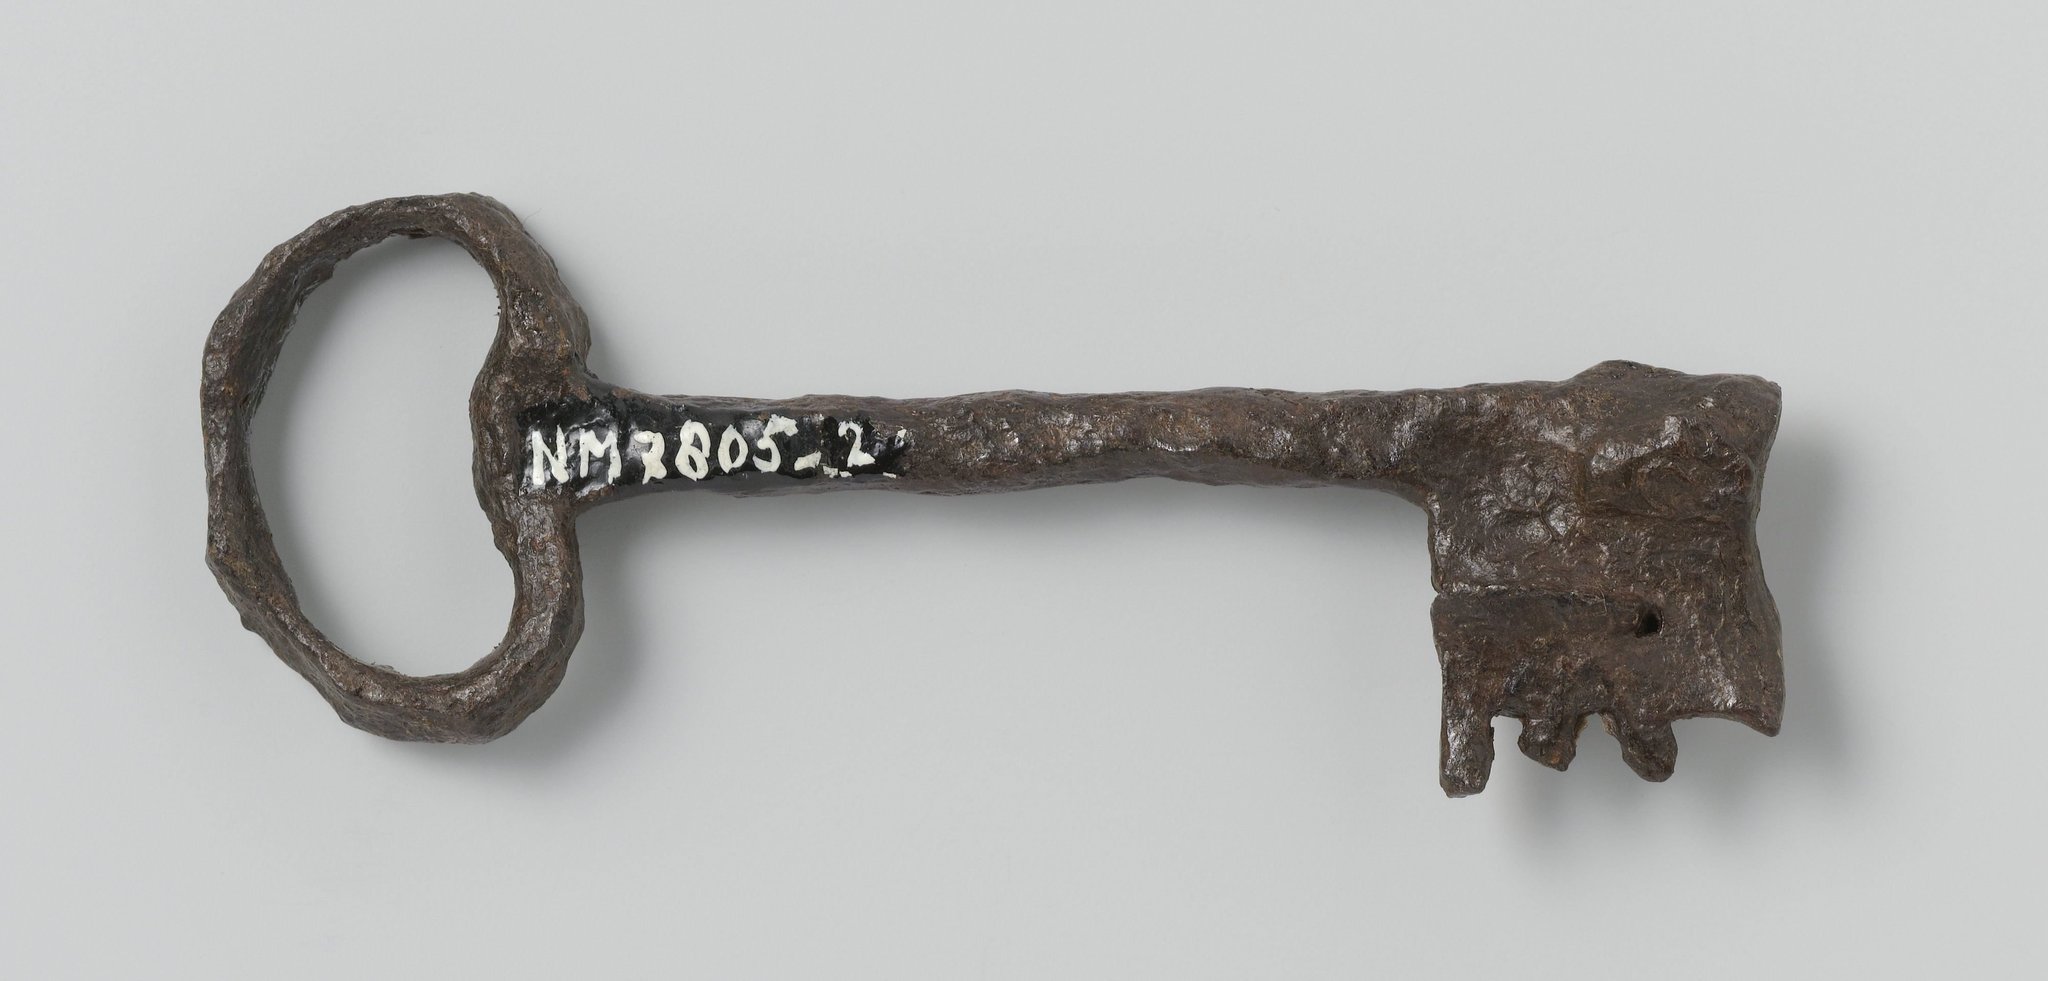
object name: key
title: Sleutel met vier tongen waarvan een is afgebroken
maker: Anonymous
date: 1590-1596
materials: iron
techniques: forging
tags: willem barendsz., amsterdam, jacob van heemskerck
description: Sleutel met vier tongen waarvan een is afgebroken.